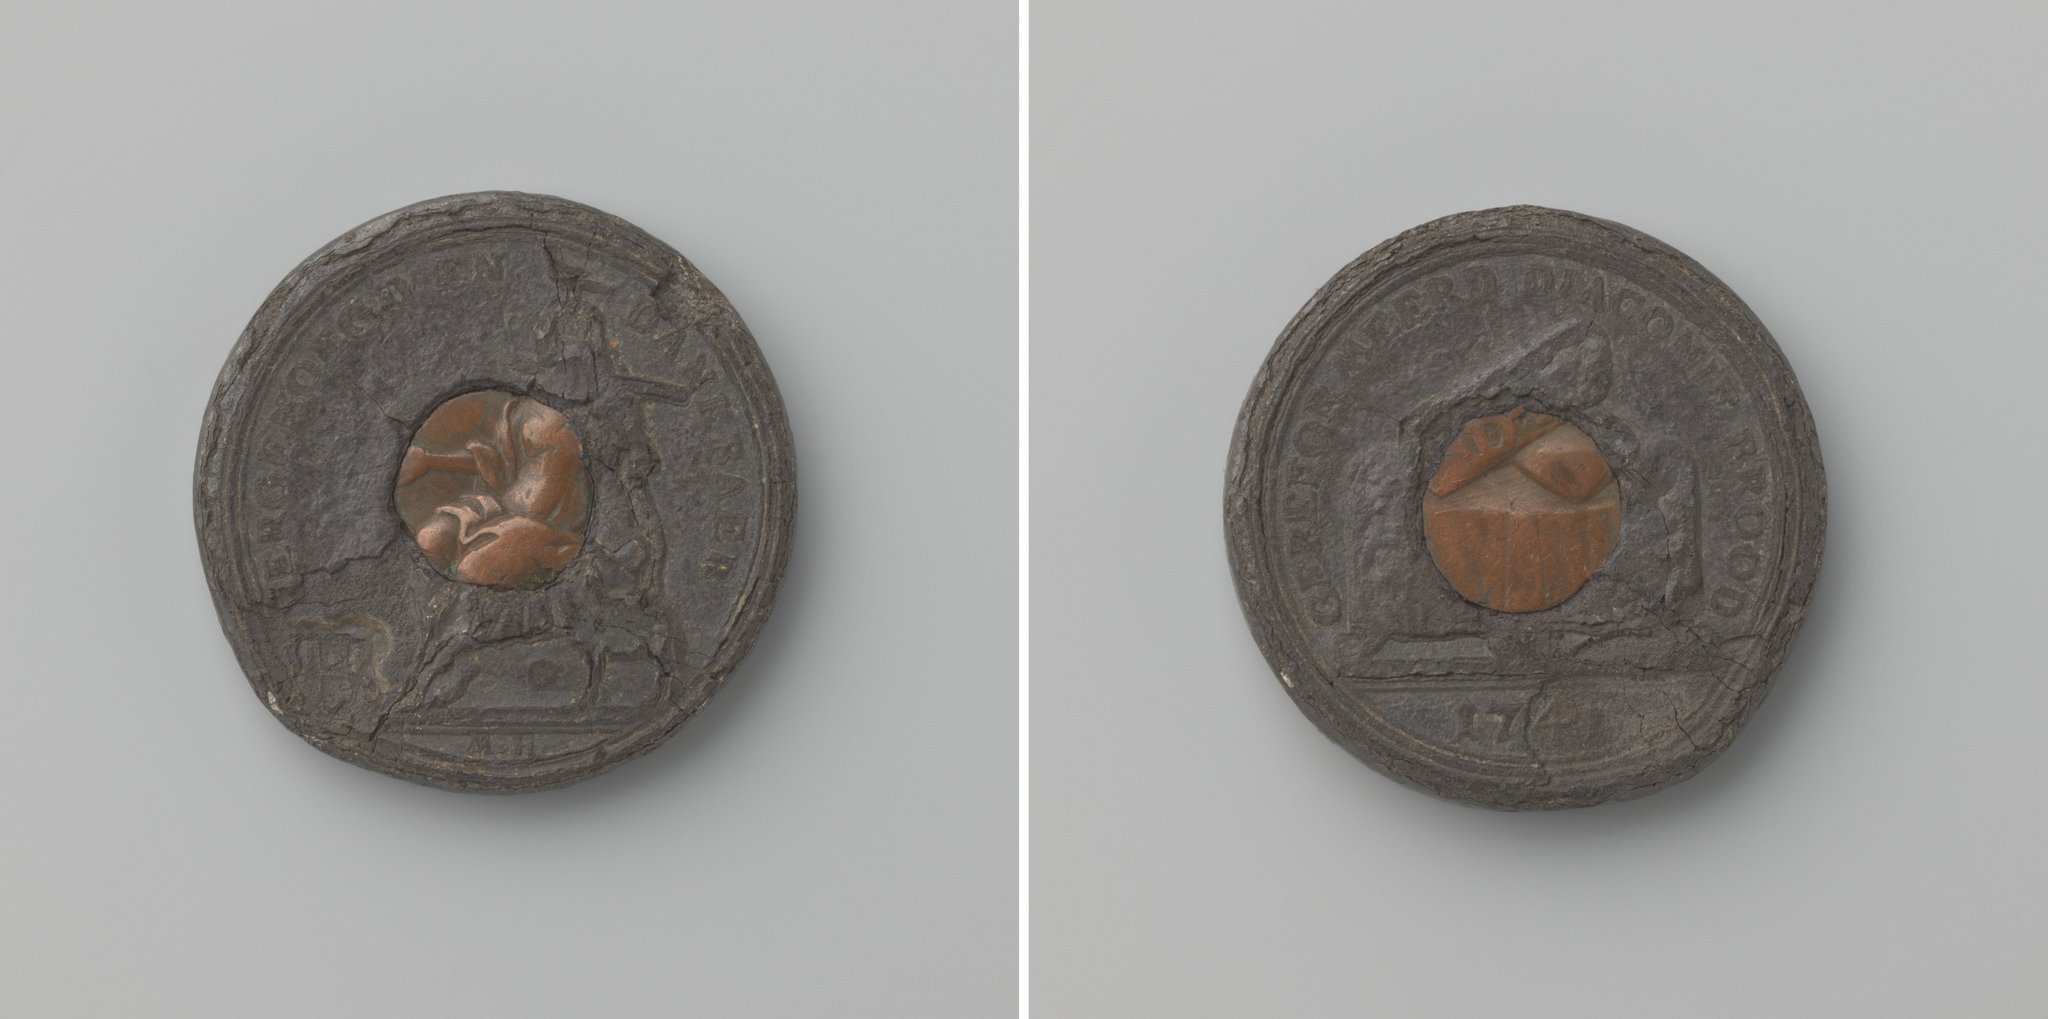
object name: alms token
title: Broodpenning van de Gereformeerde Diaconie te Amsterdam 1777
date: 1777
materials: copper, tin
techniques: striking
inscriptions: circumscription: ‘VERGENOEGD EN DANKBAAR’, circumscription: ‘GEREFORMEERD DIACONIE BROOD’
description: Tinnen penning met brede koperen plug, op de voorzijde een vrouw zittend naast een schaap, een duif op haar hoofd en een juk om haar nek, met omschrift, op de keerzijde twee broden op een beklede tafel, met omschrift, in afsnede 1777, met instempeling B op de voorzijde.